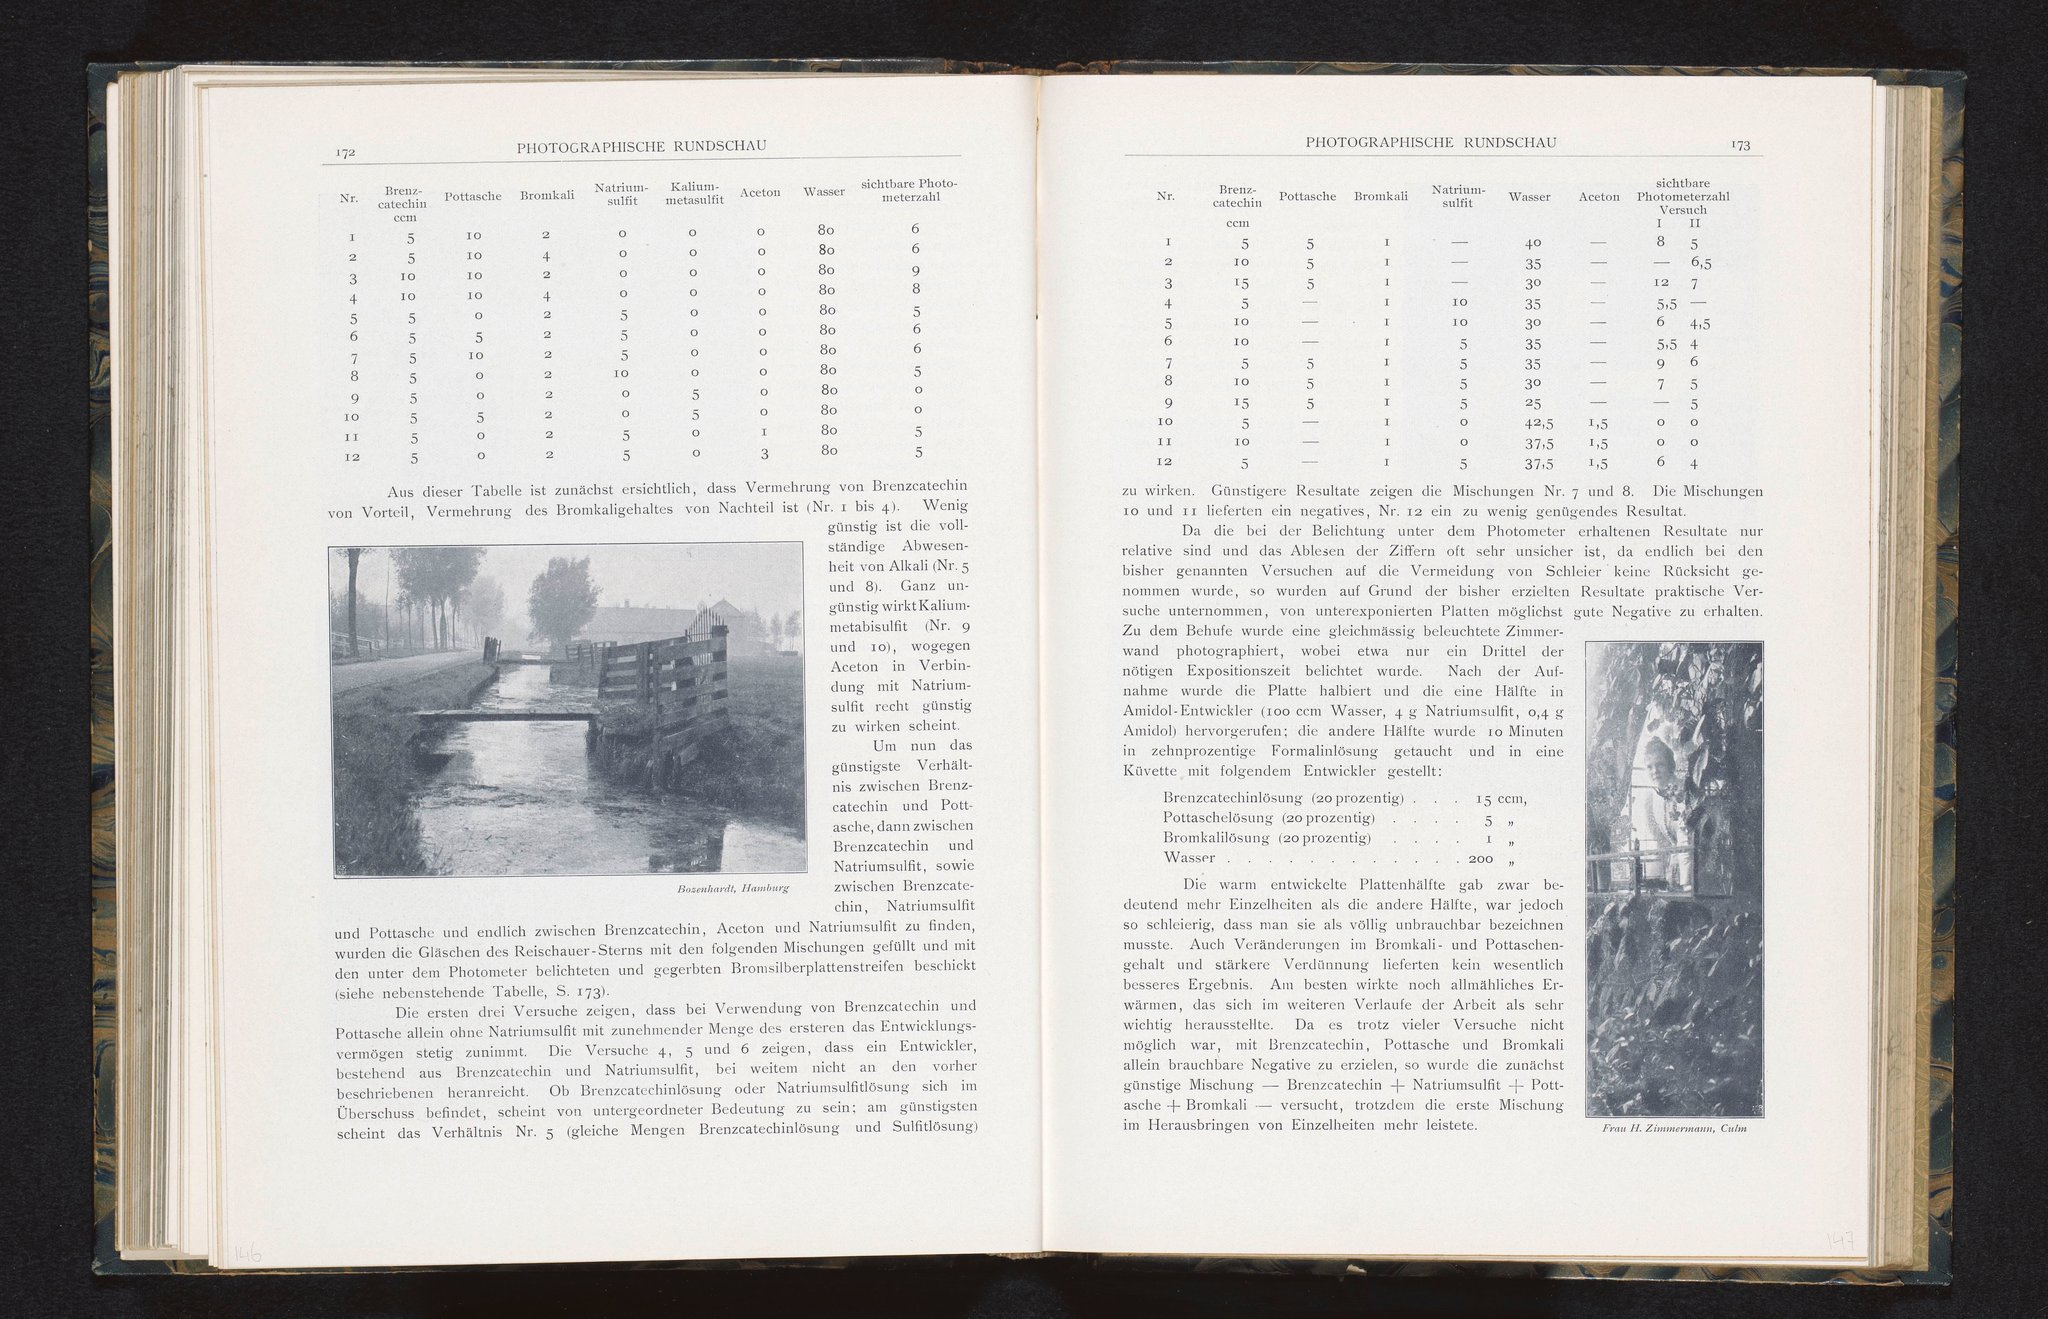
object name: page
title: Gezicht op planken als oversteek over een sloot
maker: o. bozenhardt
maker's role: fotograaf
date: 1895-1900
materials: paper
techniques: autotype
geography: berlin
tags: small canal, ditch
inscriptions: inscription: ‘MR/&Co’